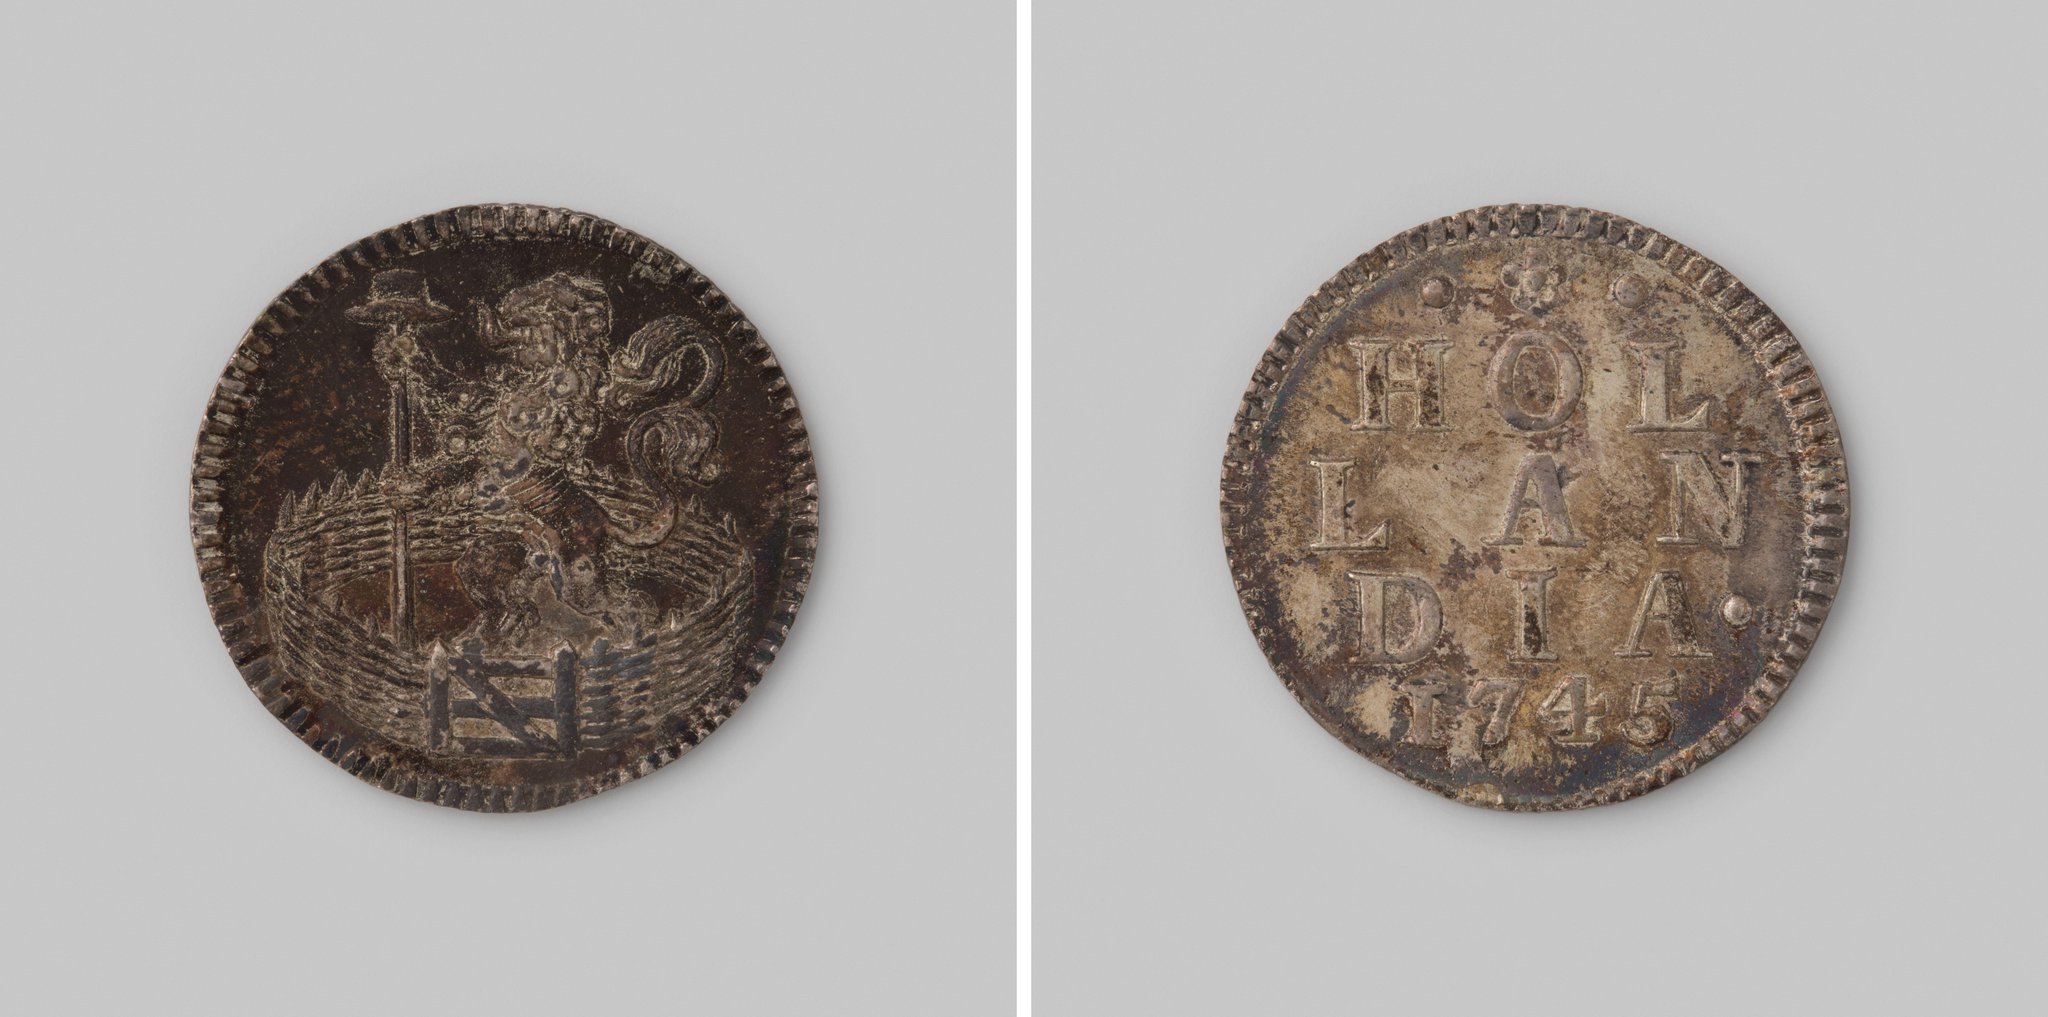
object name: coin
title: Hollandse duit, 1745. Afslag in zilver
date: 1745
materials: silver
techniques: striking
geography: dordrecht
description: Zilveren munt. Voorzijde: binnen omheining staande leeuw met vrijheidshoed op speer. Keerzijde: opschrift: provincienaam in drie regels, daaronder jaartal.